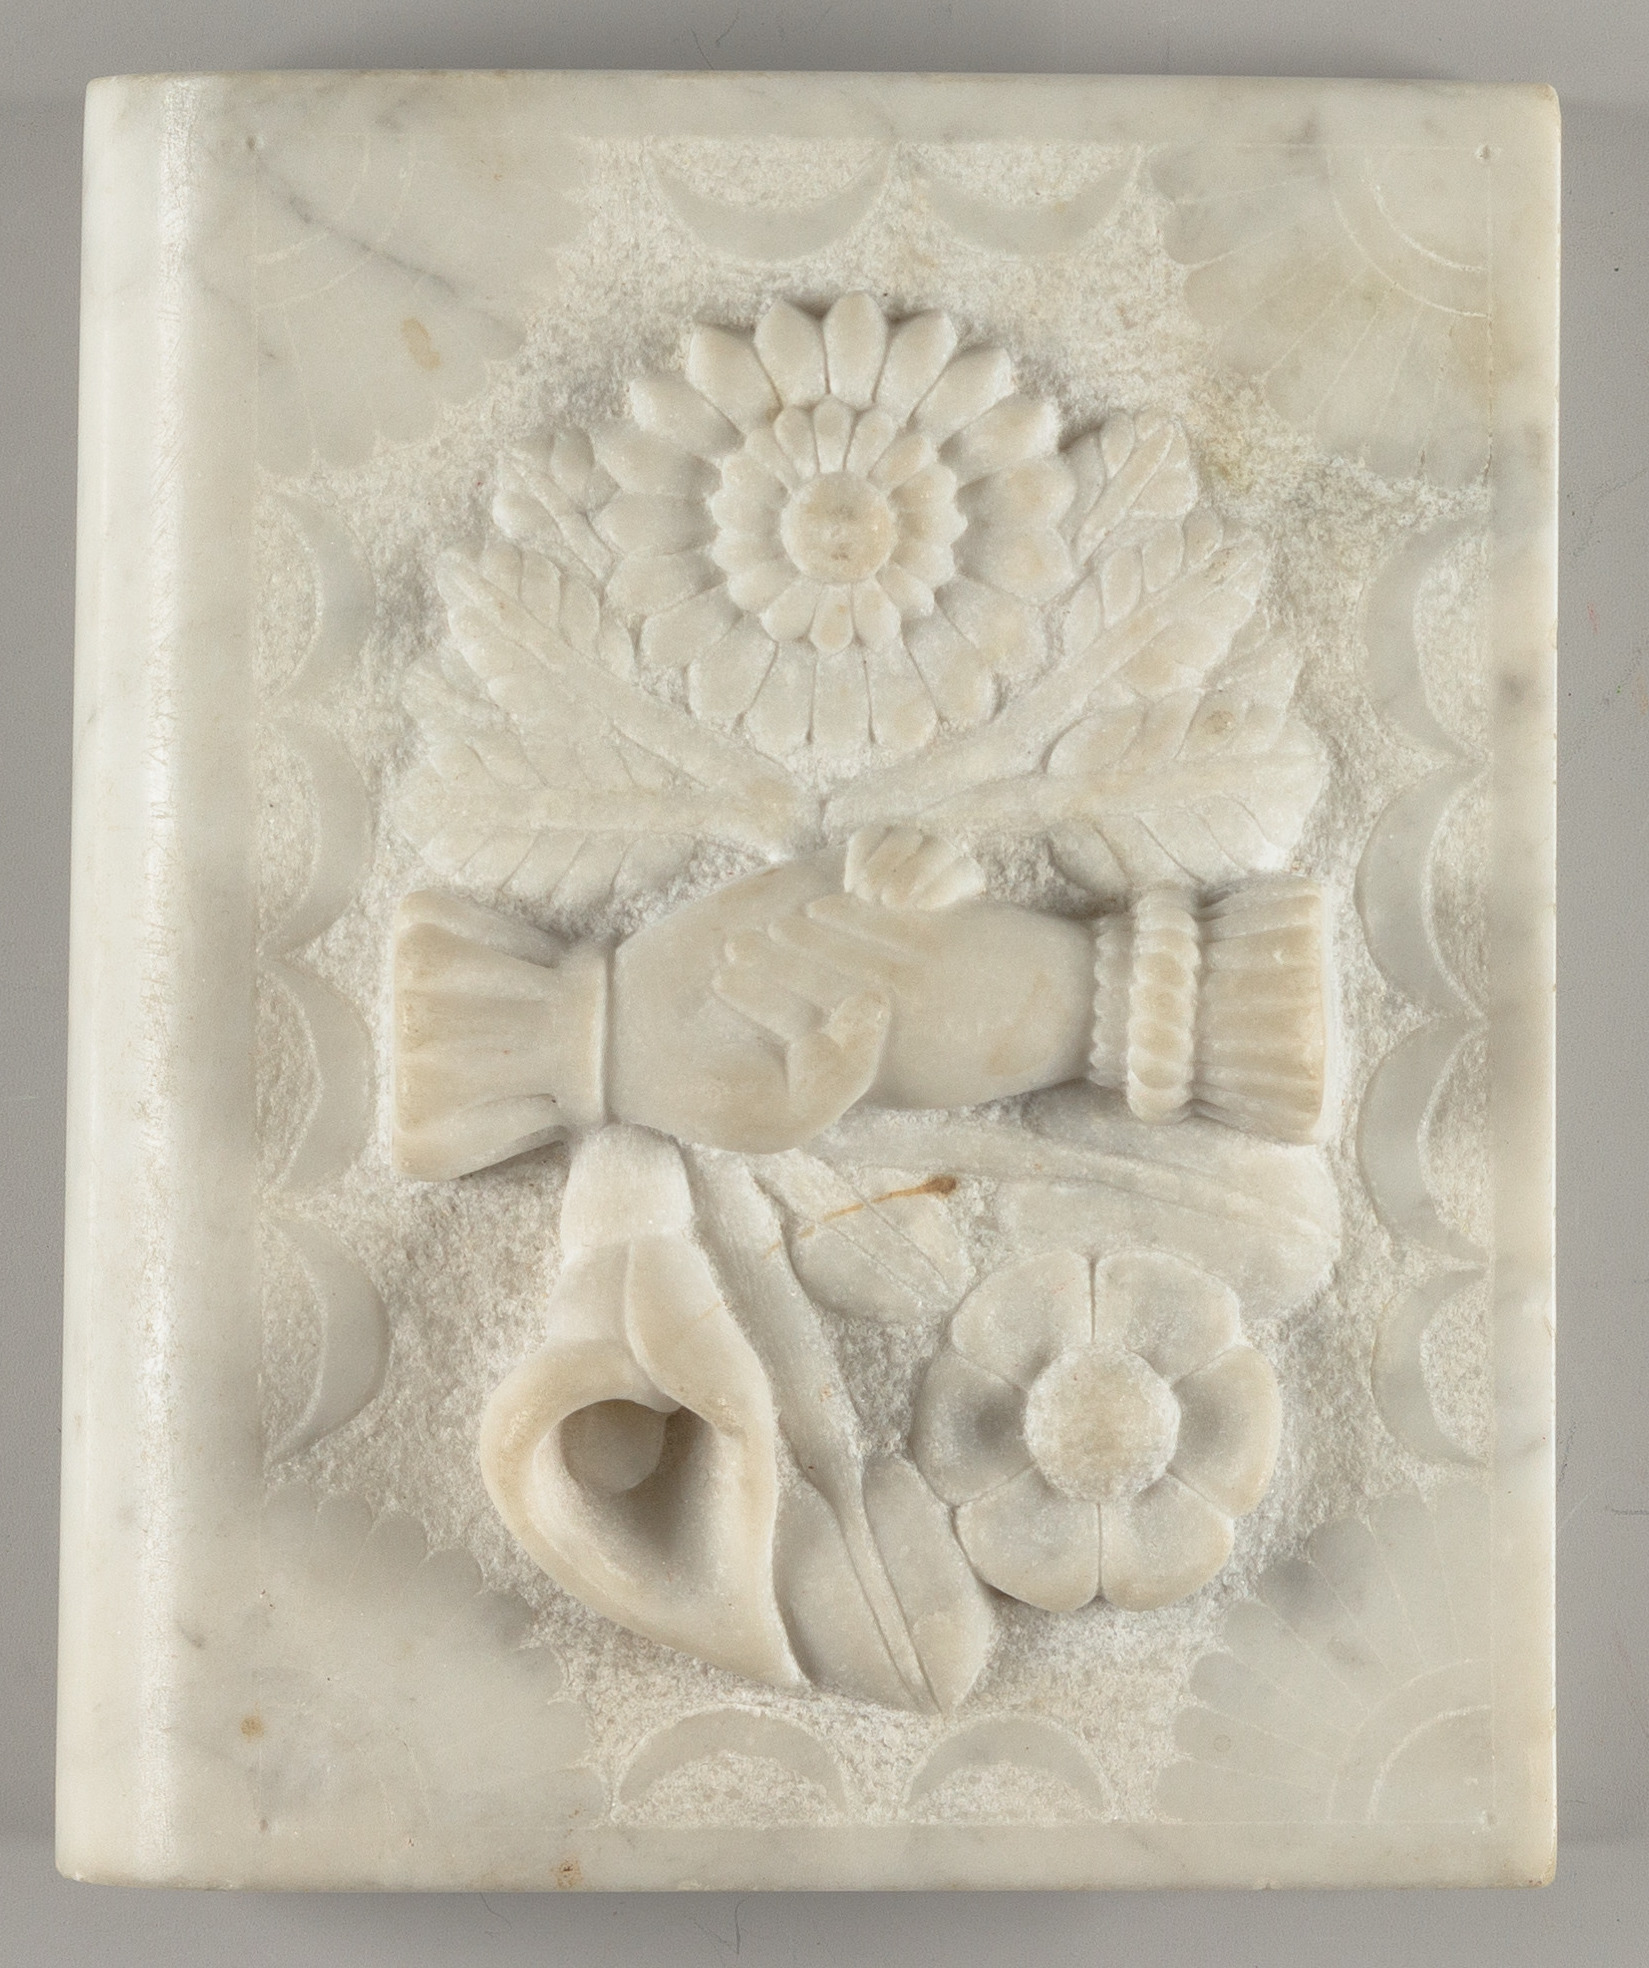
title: Marble memorial sculpture in book form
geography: united states